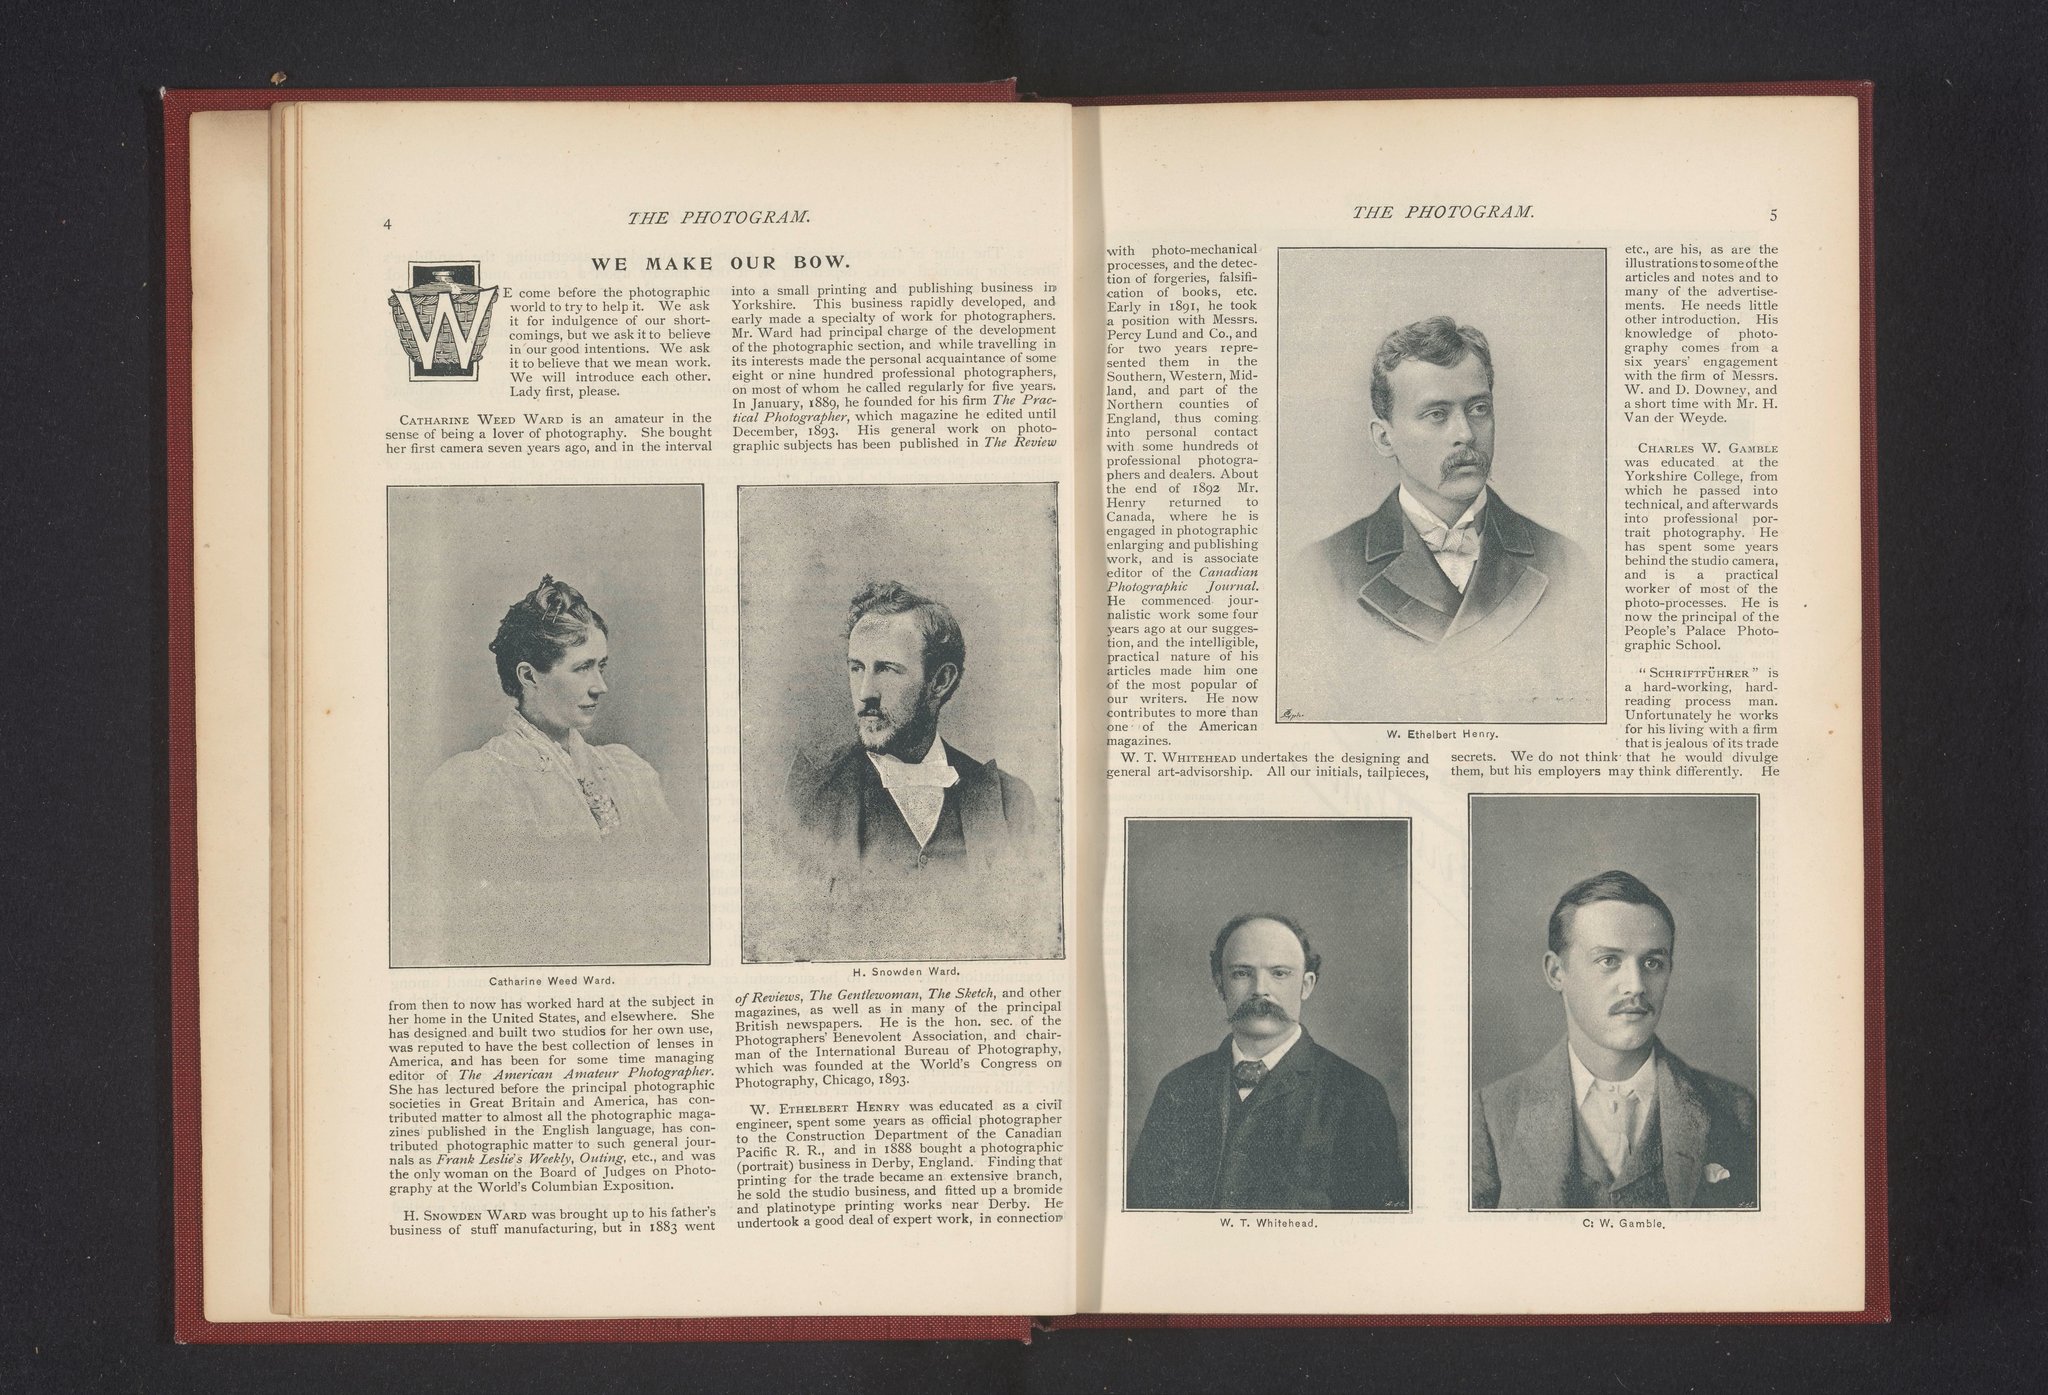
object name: page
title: Portret van Henry Snowden Ward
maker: Anonymous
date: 1889-1894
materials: paper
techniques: autotype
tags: henry snowden ward, historical persons